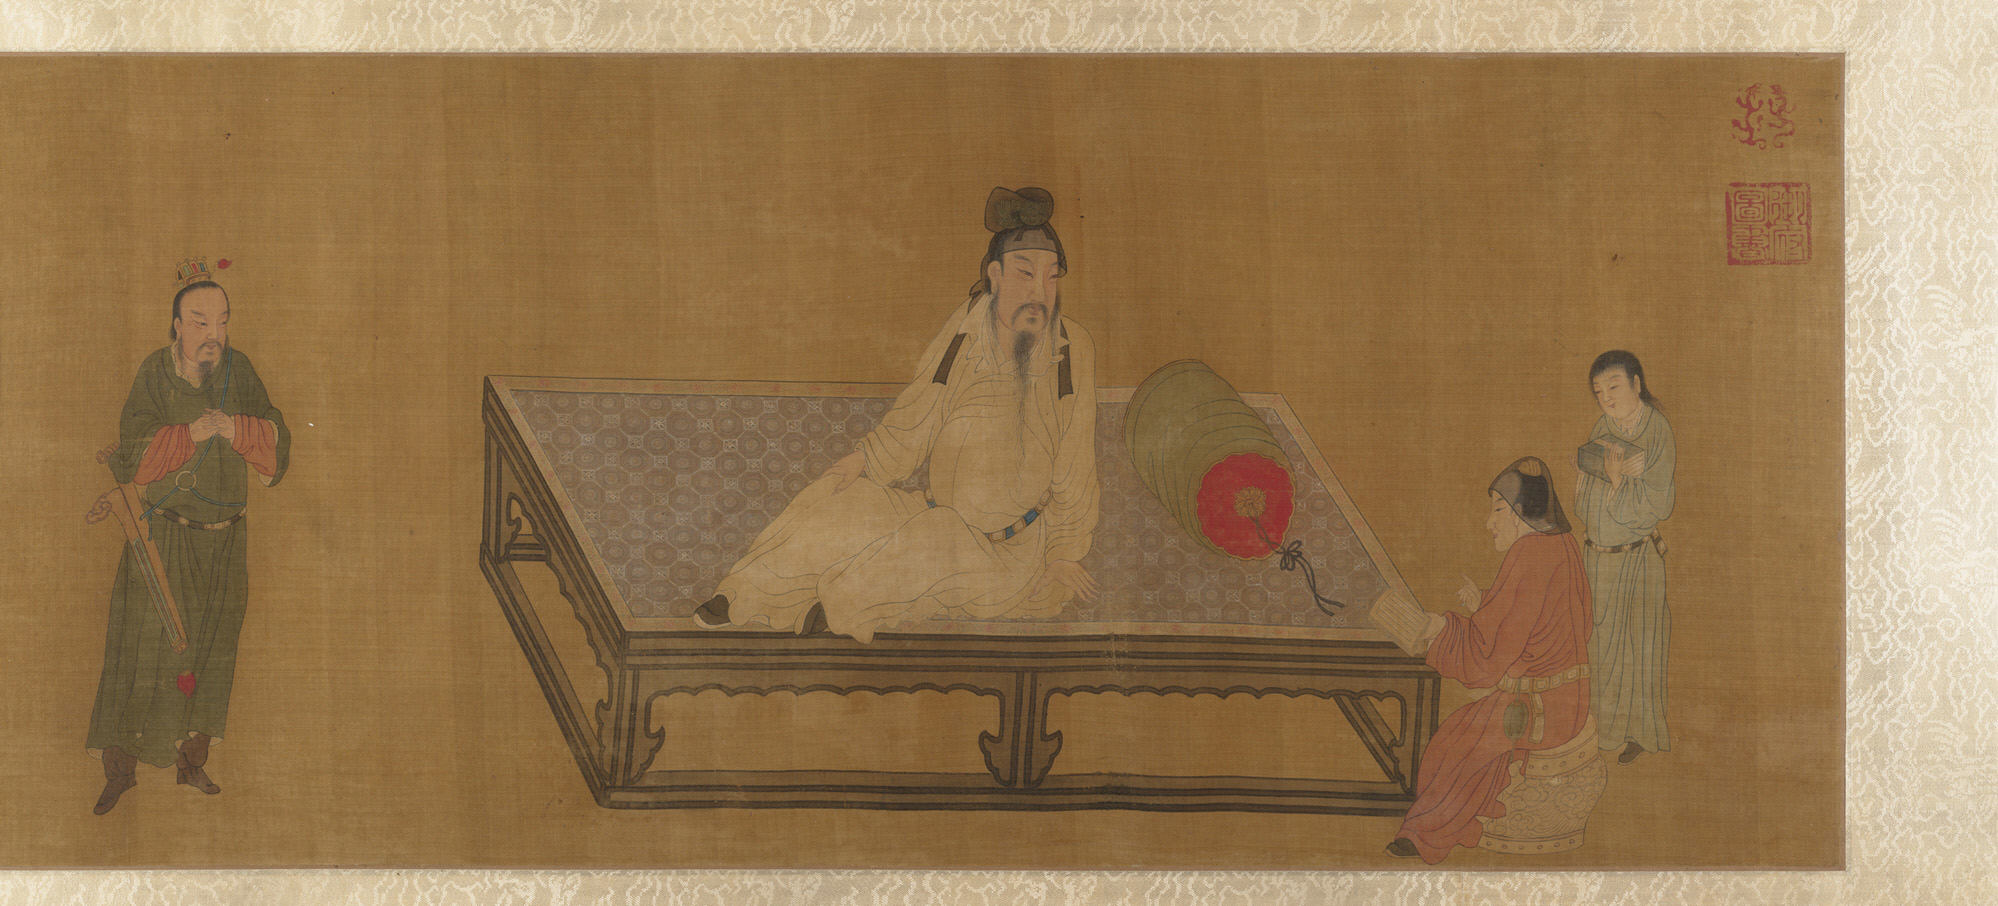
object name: handscroll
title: Copy of Tang Ming Huang Instructing the Prince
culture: chinese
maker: unidentified artist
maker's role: artist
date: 1368-1911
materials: ink, silk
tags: books,men